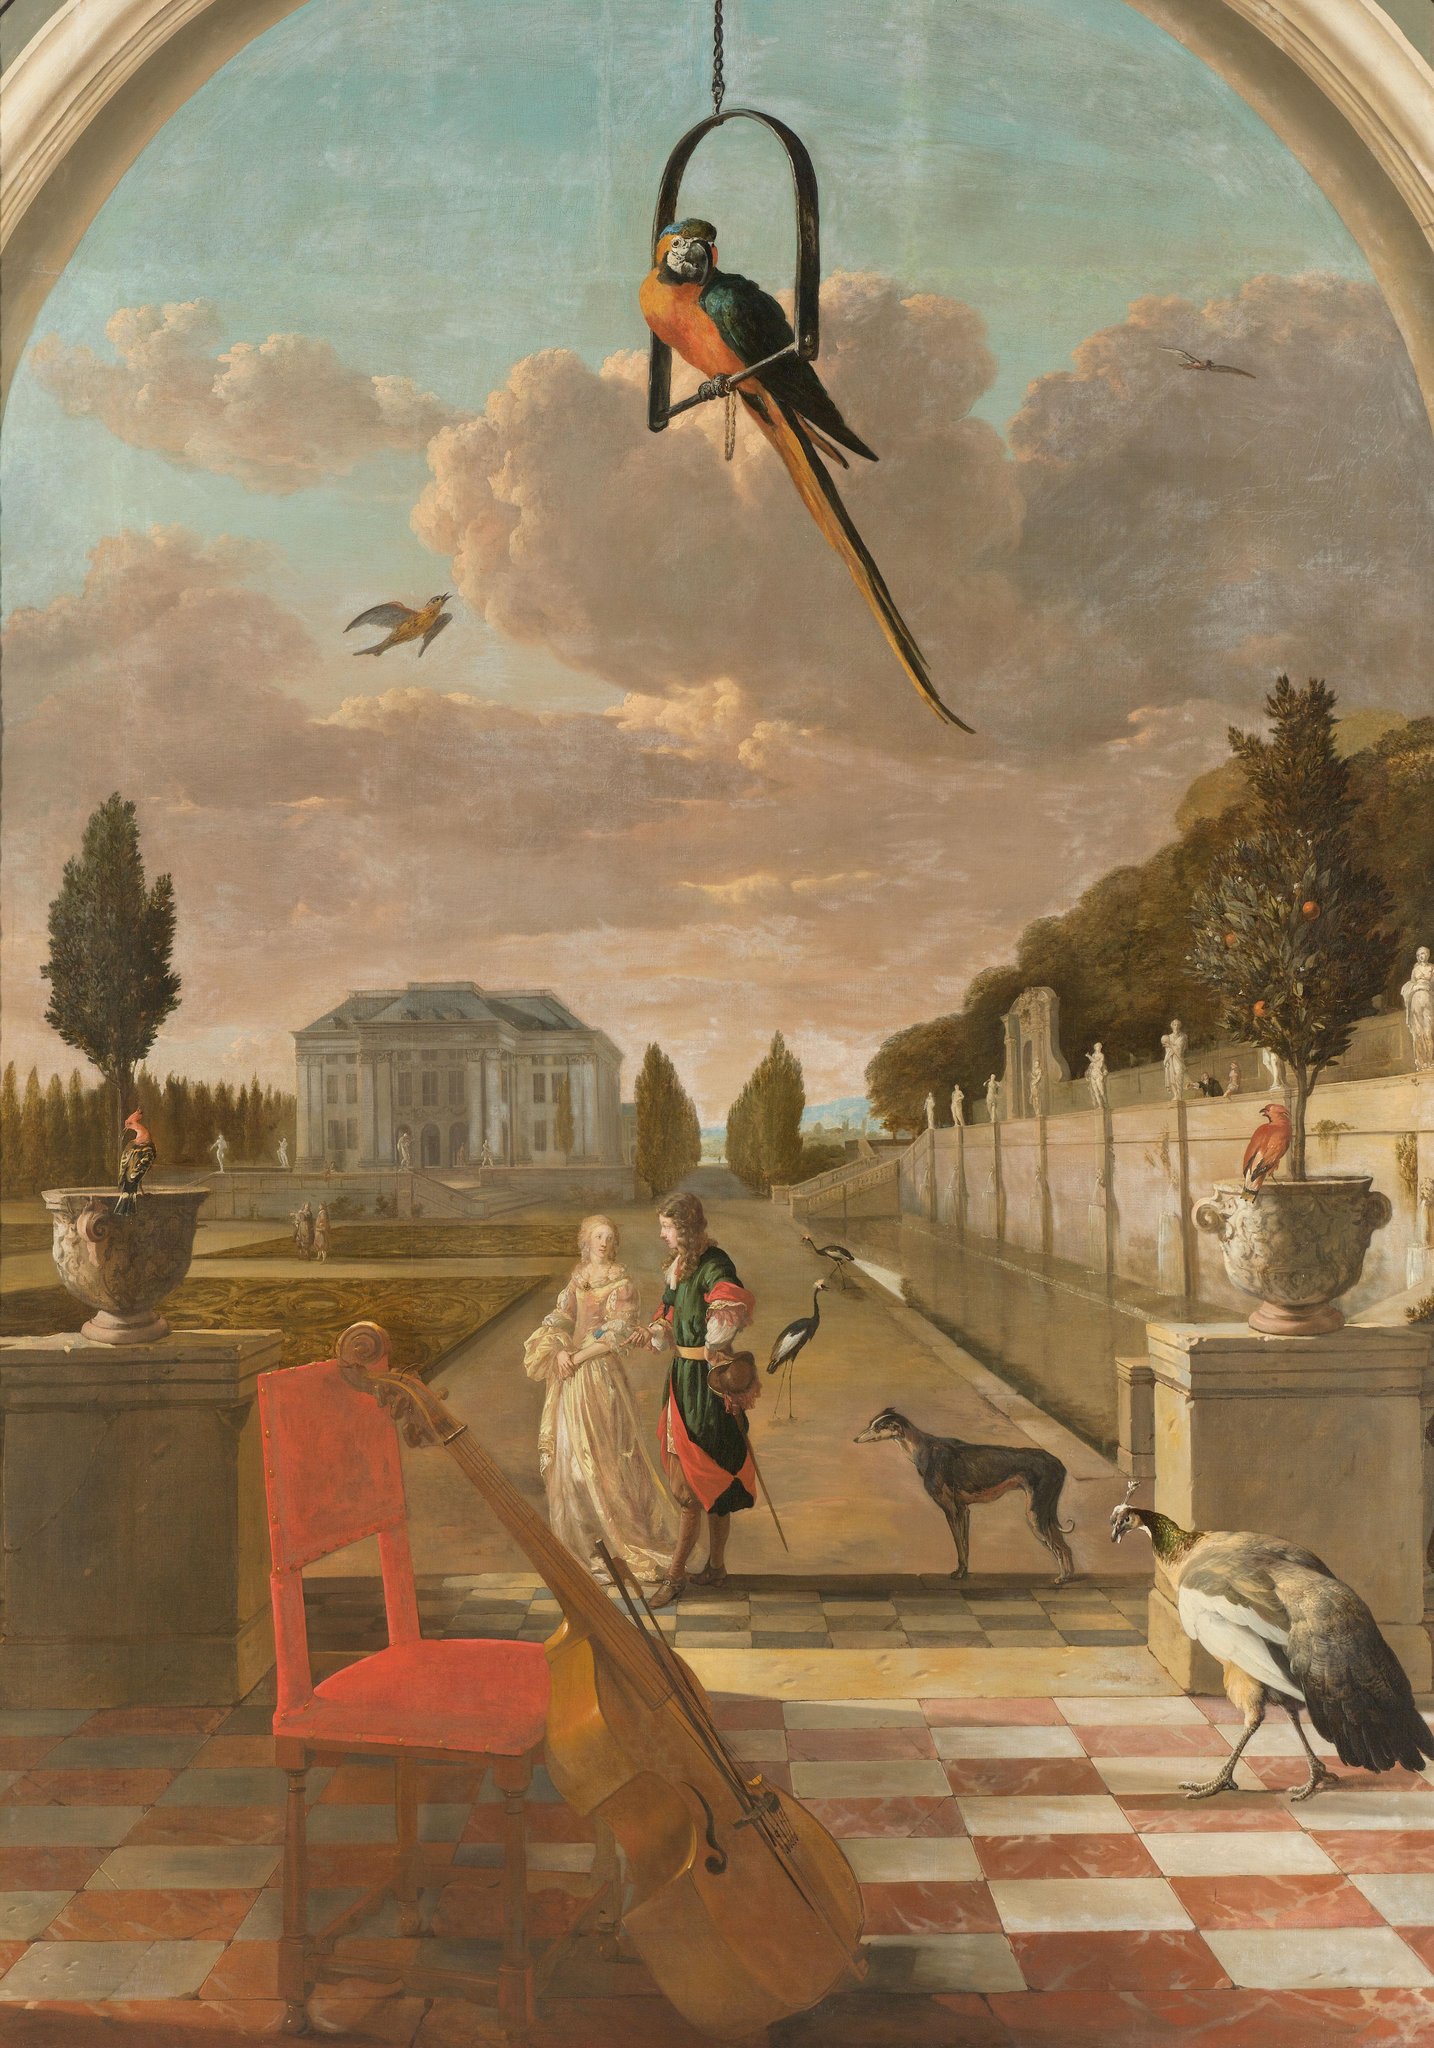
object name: fragment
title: Park with Country House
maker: jan weenix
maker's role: draughtsman, painter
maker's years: 1640-1719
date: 1670-1719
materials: canvas, oil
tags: park, viola, violoncello; double bass - cc - out of doors, birds, garden, ornamental birds: parrot, ornamental birds: peacock, dog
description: Park met buitenhuis. Gezicht vanaf een terras met tegelvloer waarop een stoel staat met daartegenaan een viola da gamba. Iets naar achteren een wandelend paar met een hond. Aan weerszijden van het terras staan potten met sinaasappelboompjes. Op de rand van de linker pot zit een hop, op de rand van de rechter pot een pestvogel. Rechts een muur met beelden en een langwerpige vijver, op de achtergrond een landhuis. Boven het terras zit een blauw-gele ara (Ara ararauna) op een stok, verder ook andere vogels waaronder een zwarte kroonkraanvogel en een pauw. Deel van een zesdelige kamerbeschildering waarvan een ander deel bewaard wordt in de collectie van Musée de la Chartreuse, Douai.